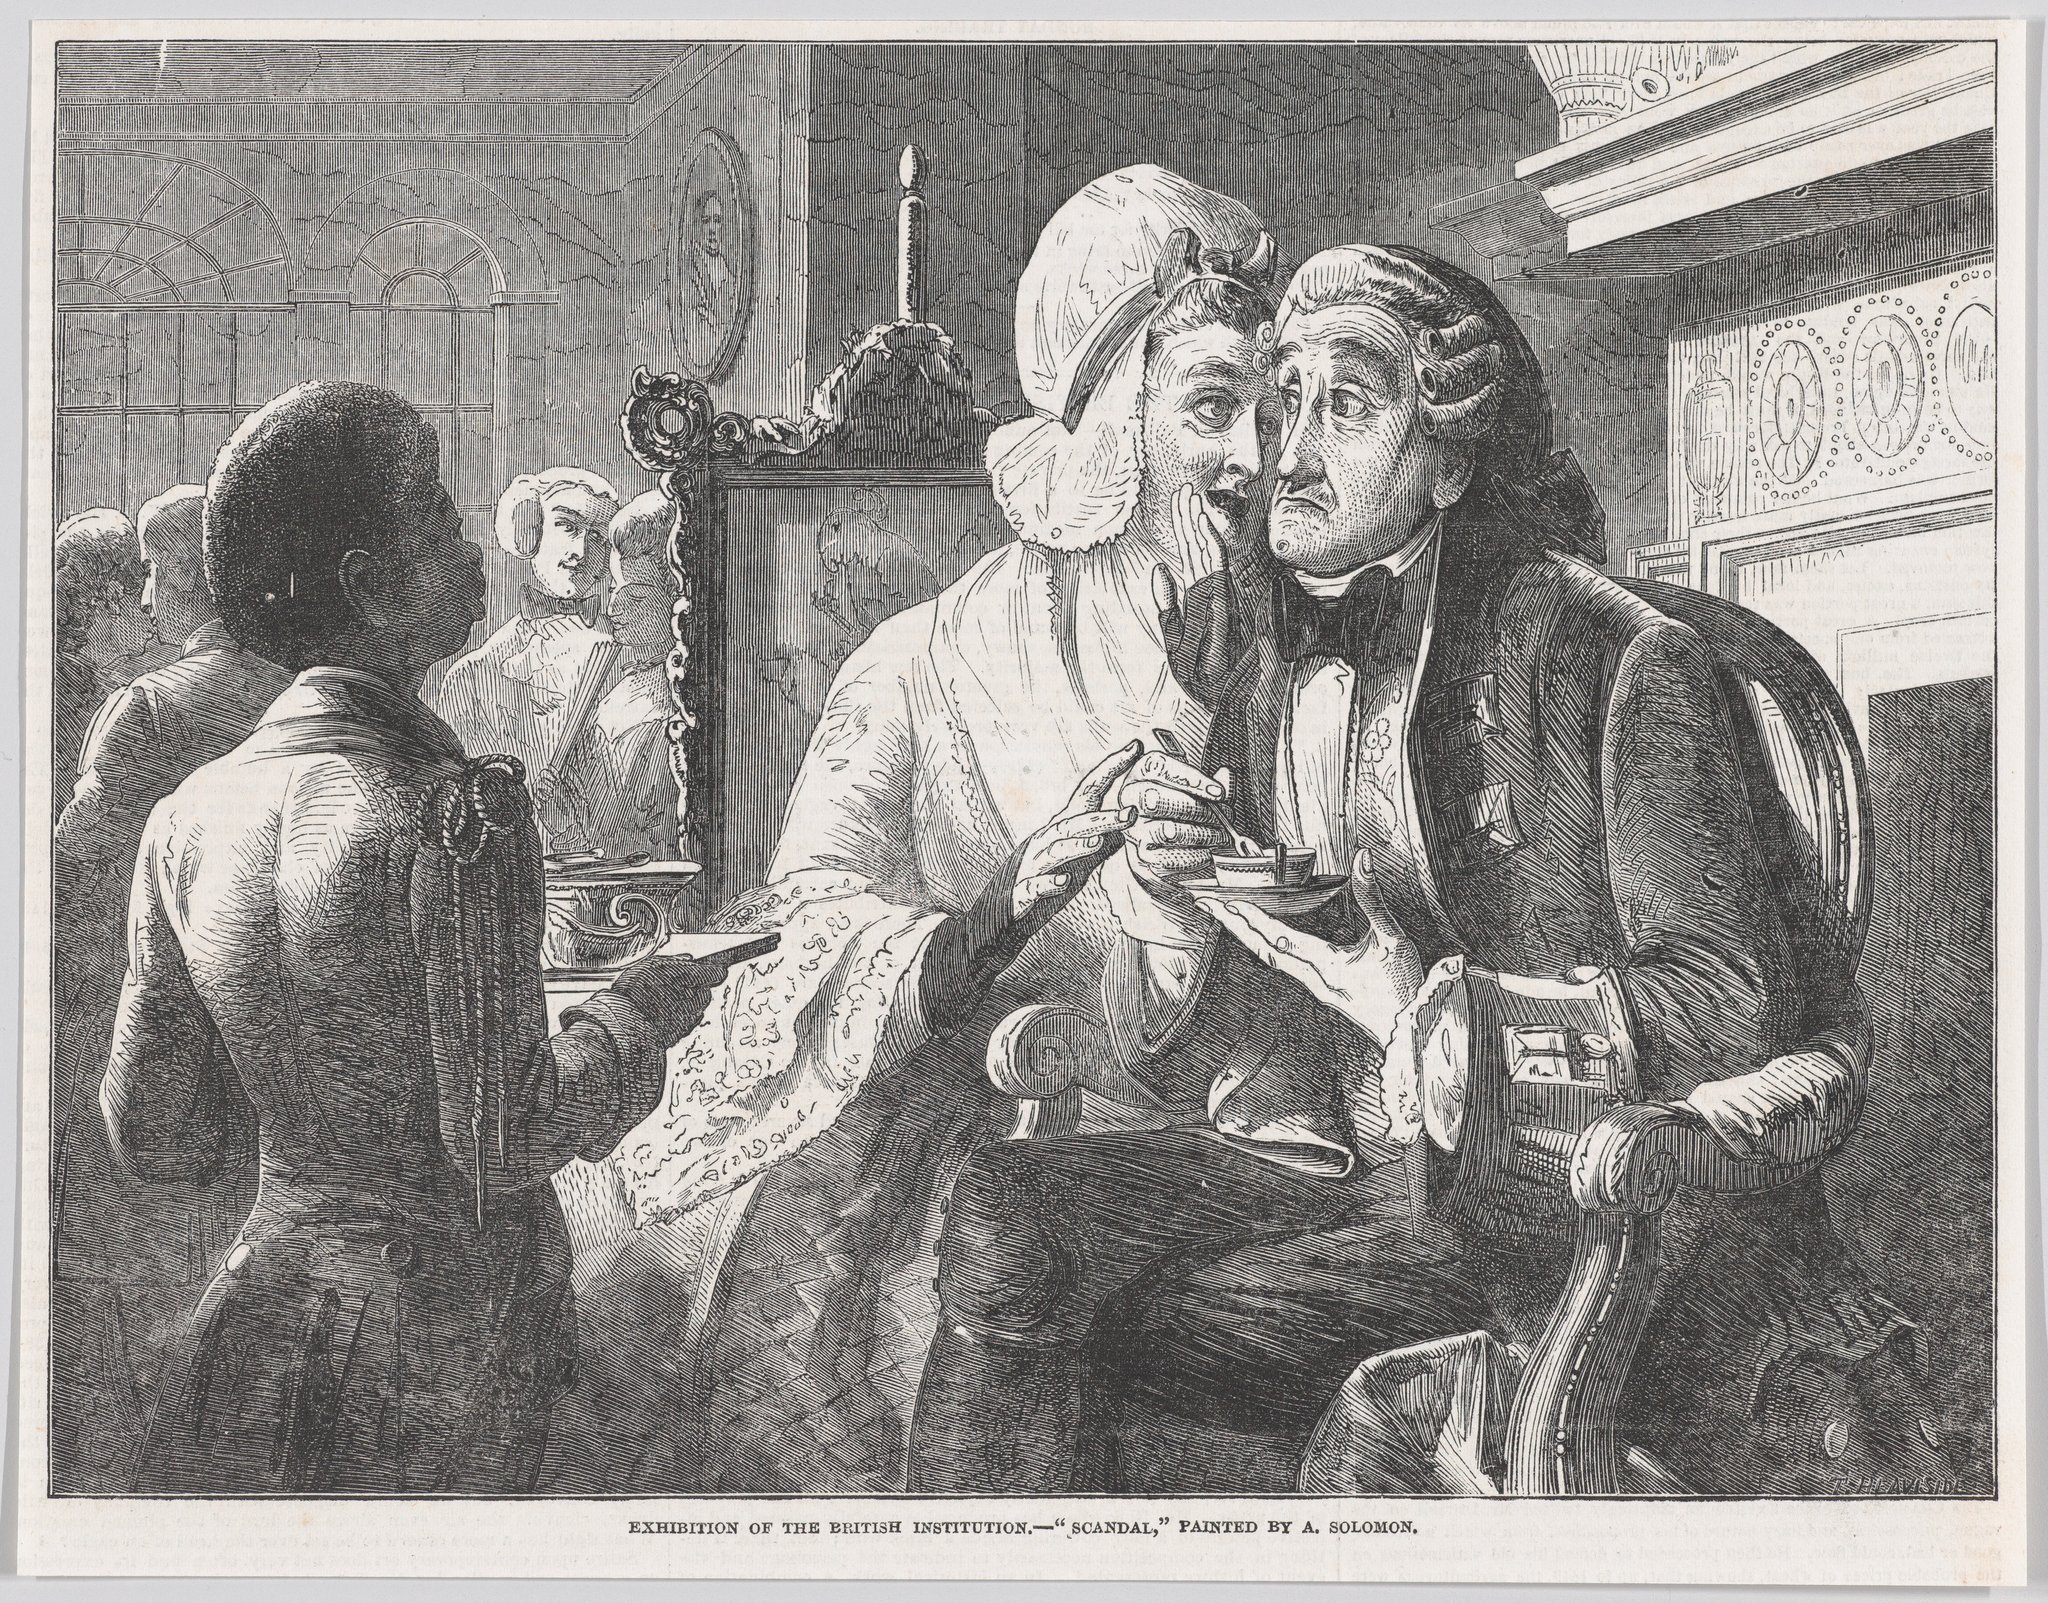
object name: print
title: Scandal, from "Illustrated London News"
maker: thomas heaviside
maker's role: engraver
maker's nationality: british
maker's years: 1813-1896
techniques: engraving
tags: men,women